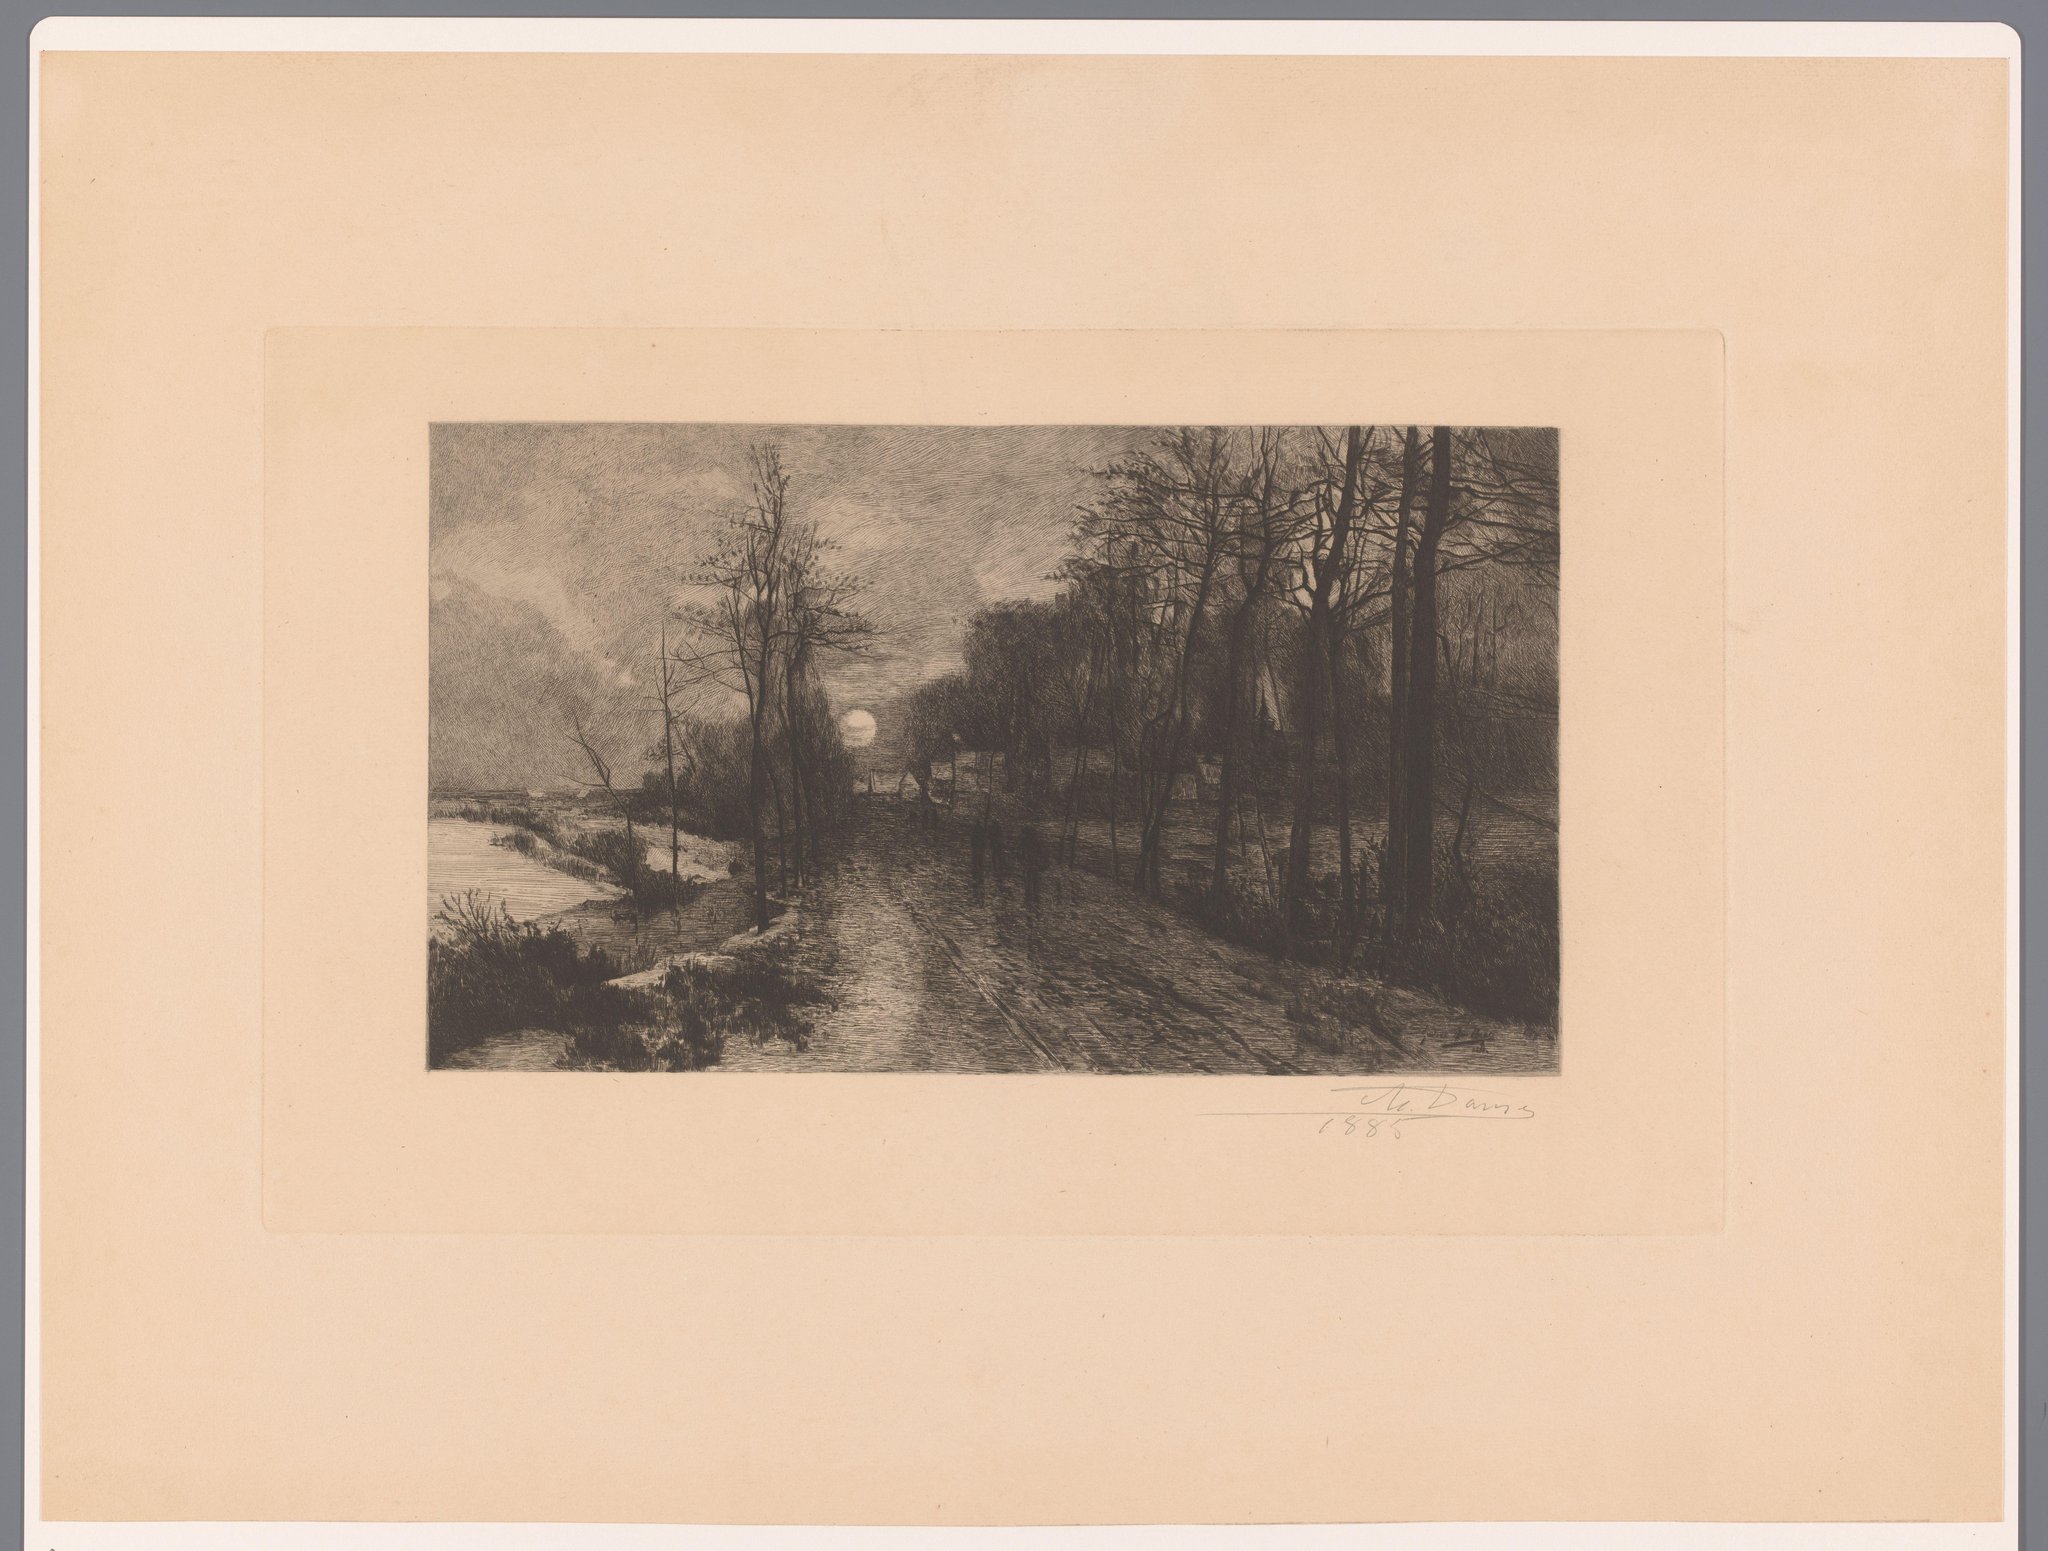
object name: print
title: Nachtelijk winterlandschap met schimmige figuren op het pad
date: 1885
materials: paper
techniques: drypoint, etching, intaglio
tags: full moon, night ~ landscape (sometimes titled 'nox')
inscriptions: collector's mark: Lugt 2228